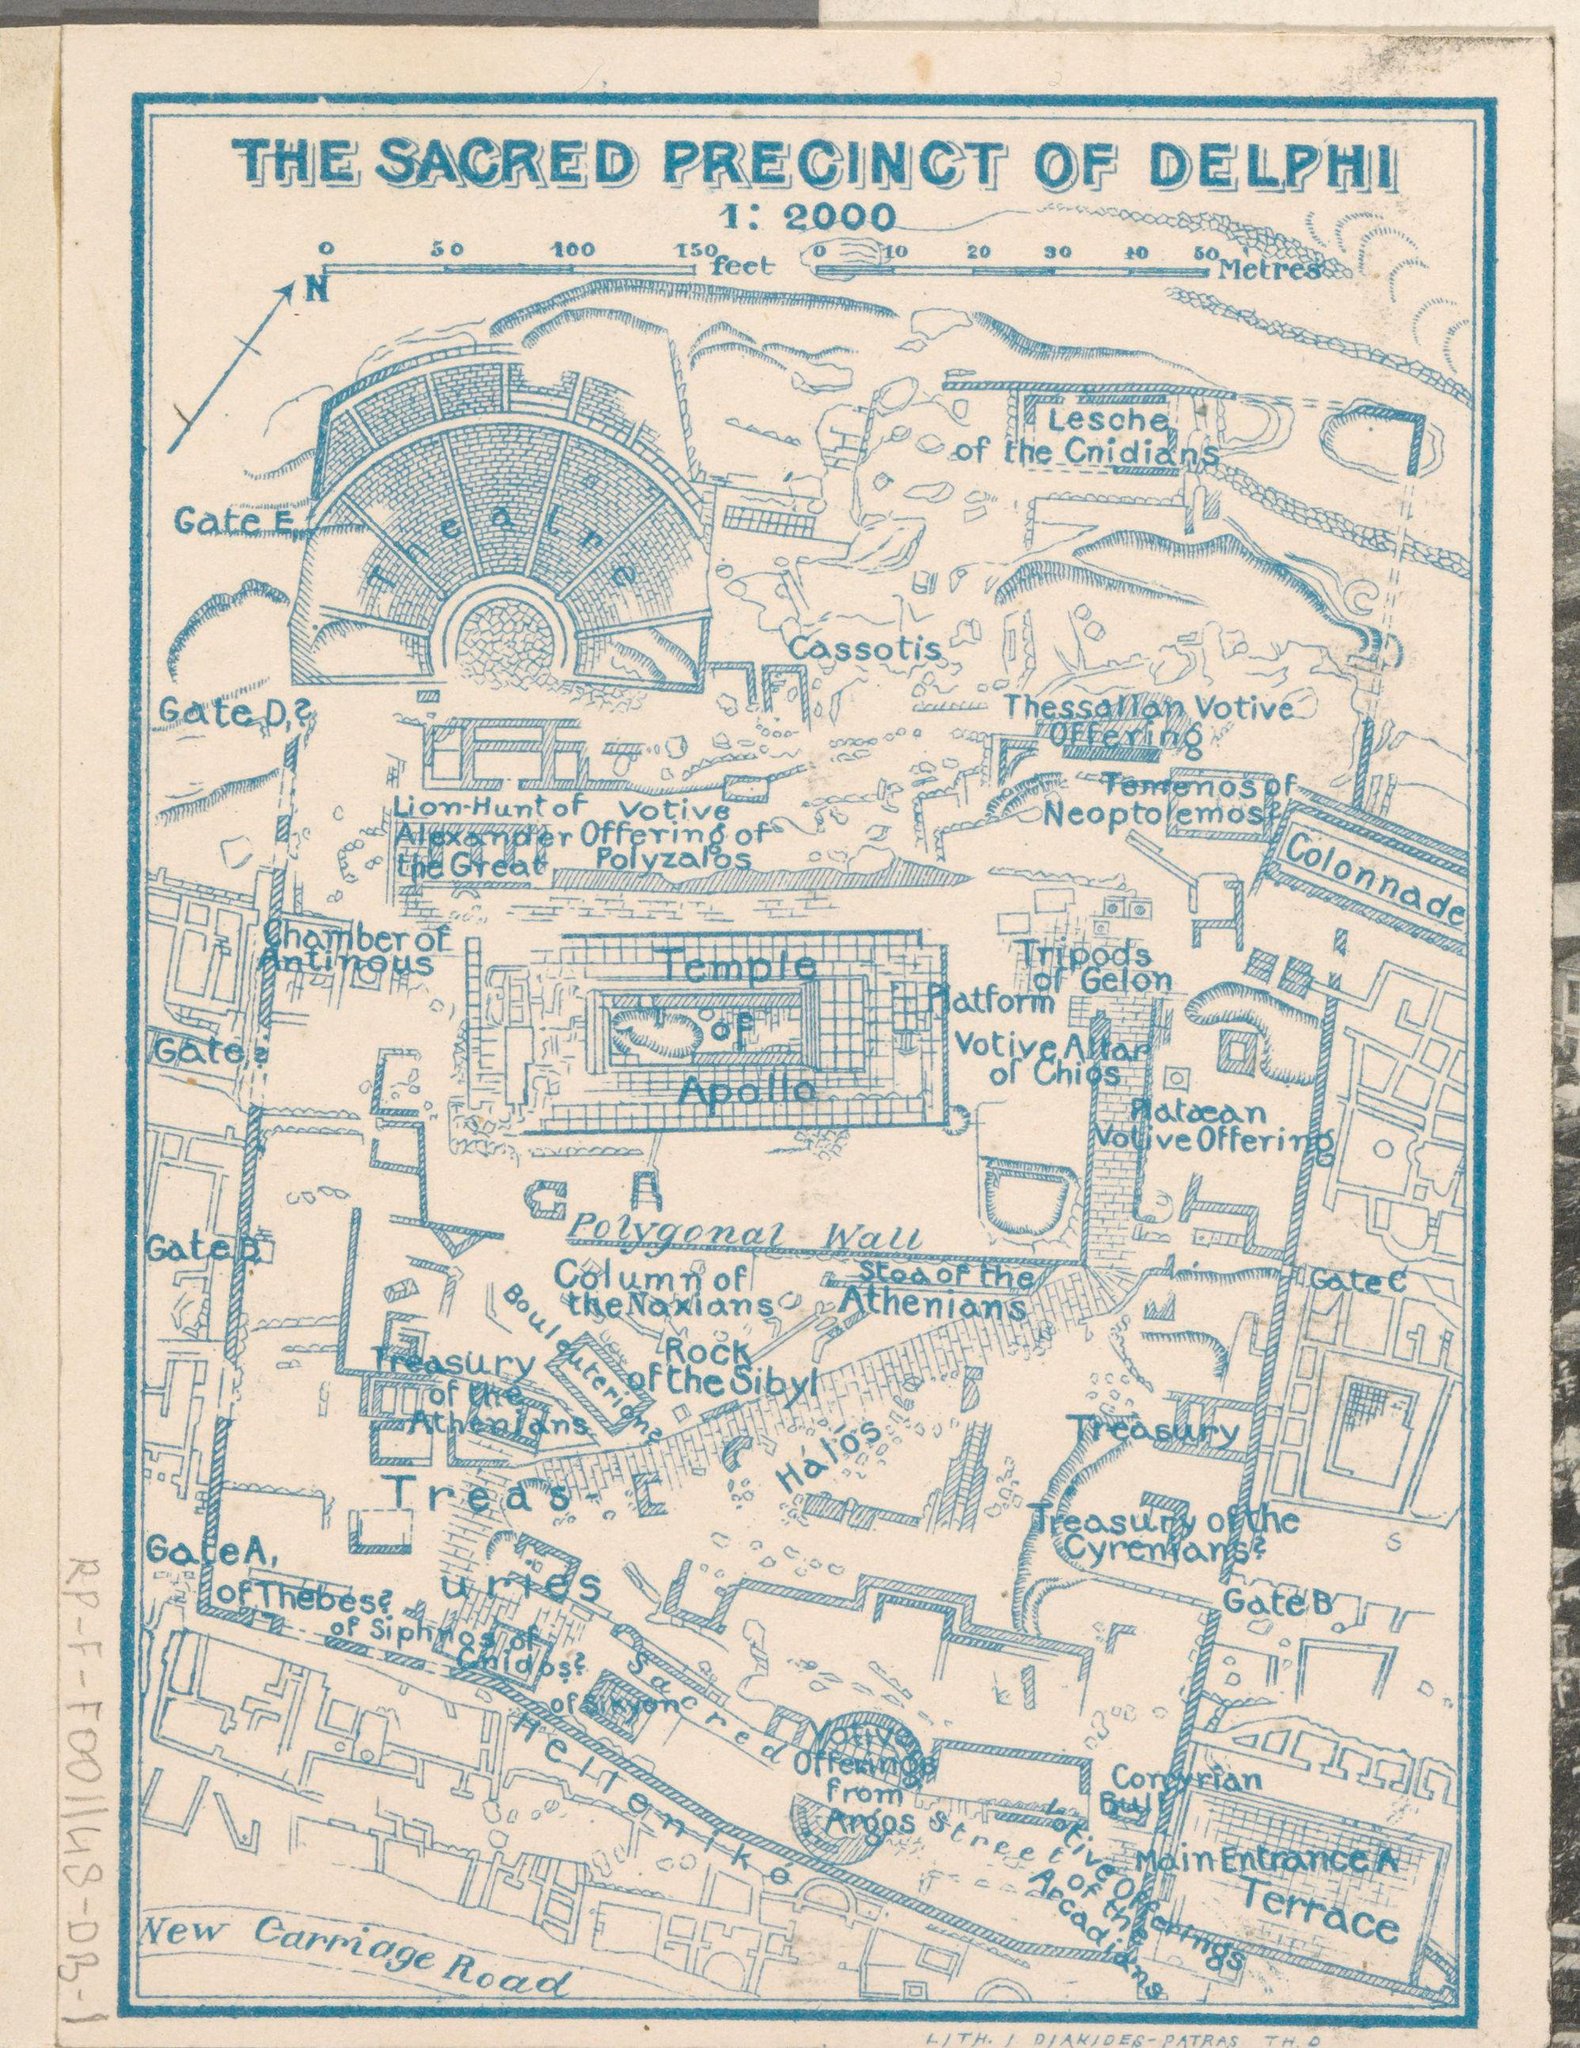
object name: area plan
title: Plattegrond van de opgravingen van Delphi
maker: j. djanides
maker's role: drukkerij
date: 1895-1905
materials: paper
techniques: printed materials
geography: patras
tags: maps, atlases, excavation ~ archaeology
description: Plattegrond van de opgravingen van Delphi, behorend bij foto RP-F-F01148-DB. Blijkens opdruk op de achterzijde werd deze vermoedelijk uitgereikt aan gasten van Le Grand Hôtel Apollon Pythien in Delphi. Onderdeel van Reisalbum met foto's van bezienswaardigheden in Griekenland en Egypte.